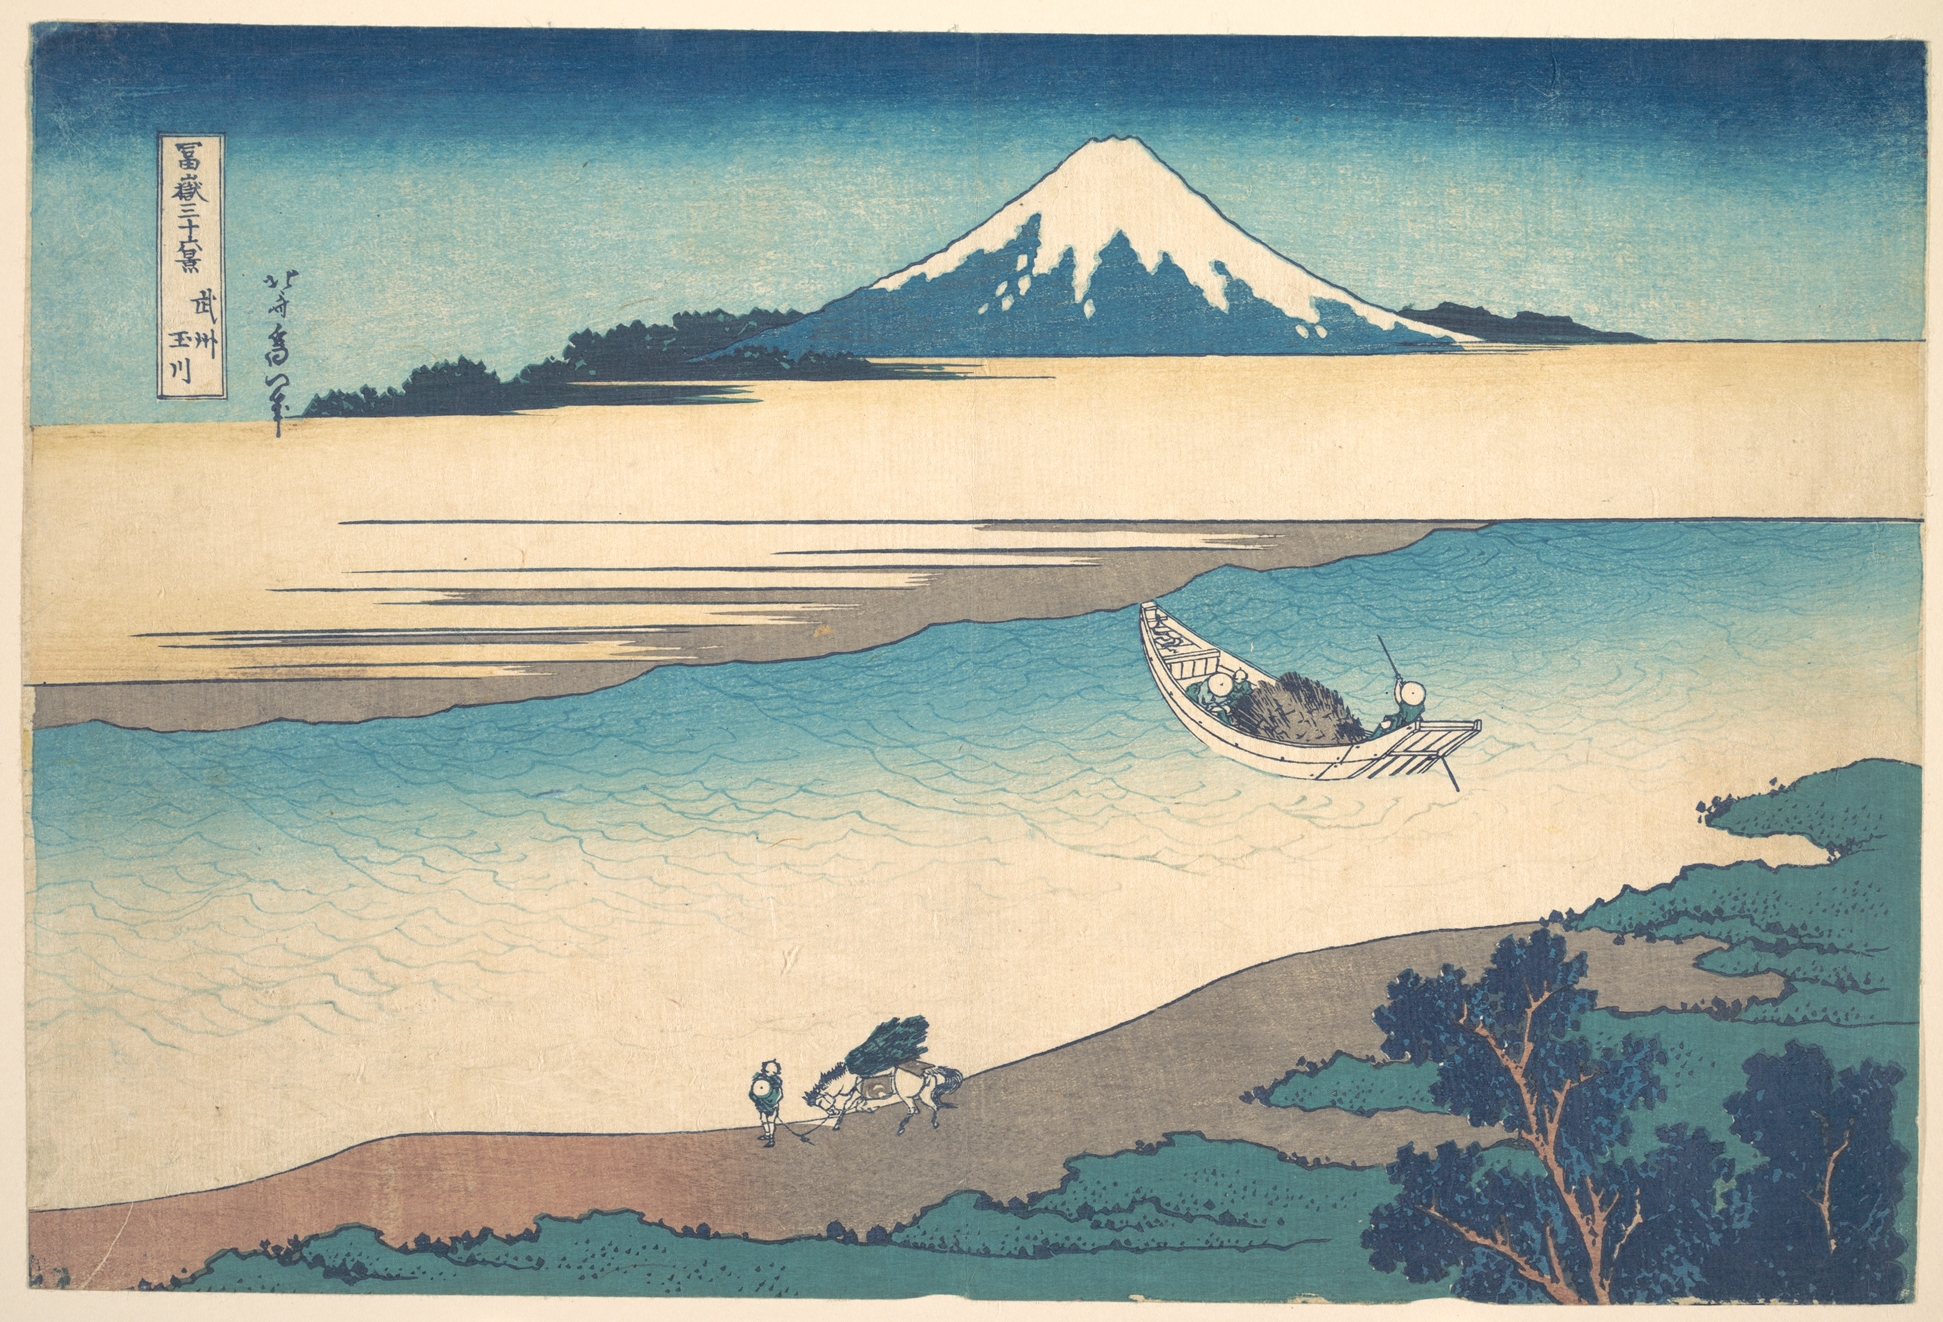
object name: woodblock print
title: Tama River in Musashi Province (Bushū Tamagawa), from the series Thirty-six Views of Mount Fuji (Fugaku sanjūrokkei)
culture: japanese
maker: katsushika hokusai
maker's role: artist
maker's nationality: japanese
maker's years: 1760-1849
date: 1830-1832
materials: ink, paper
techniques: woodblock print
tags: horses,rivers,mountains,trees,boats